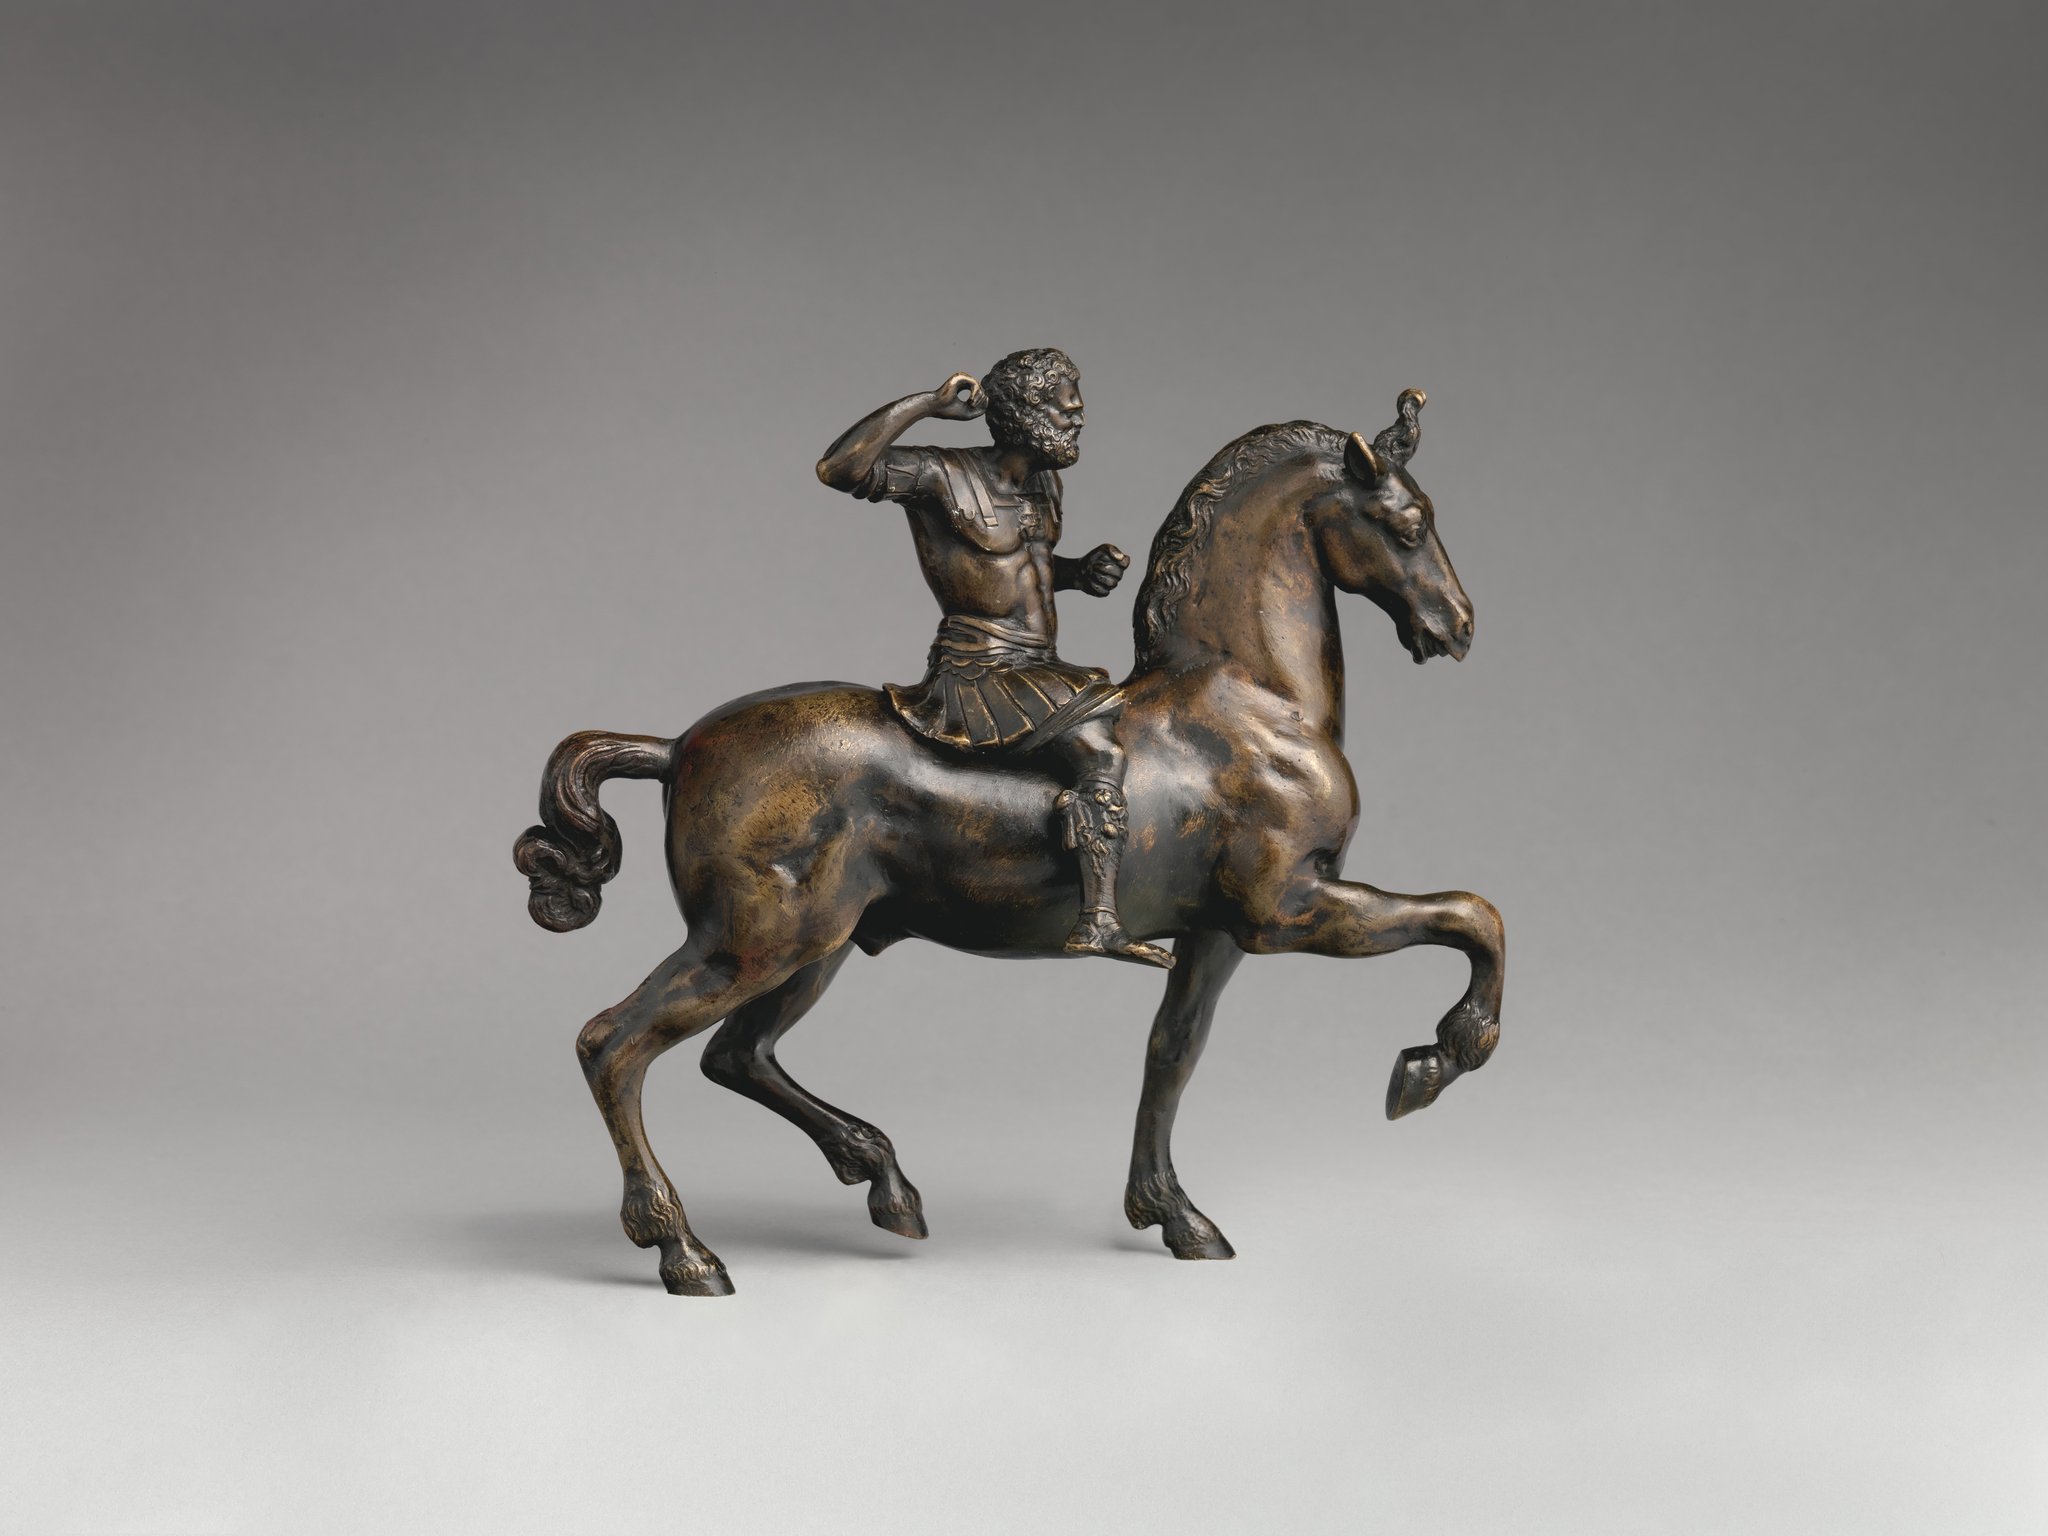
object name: statuette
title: Horse and rider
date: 1534-1566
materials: bronze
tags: men,horses